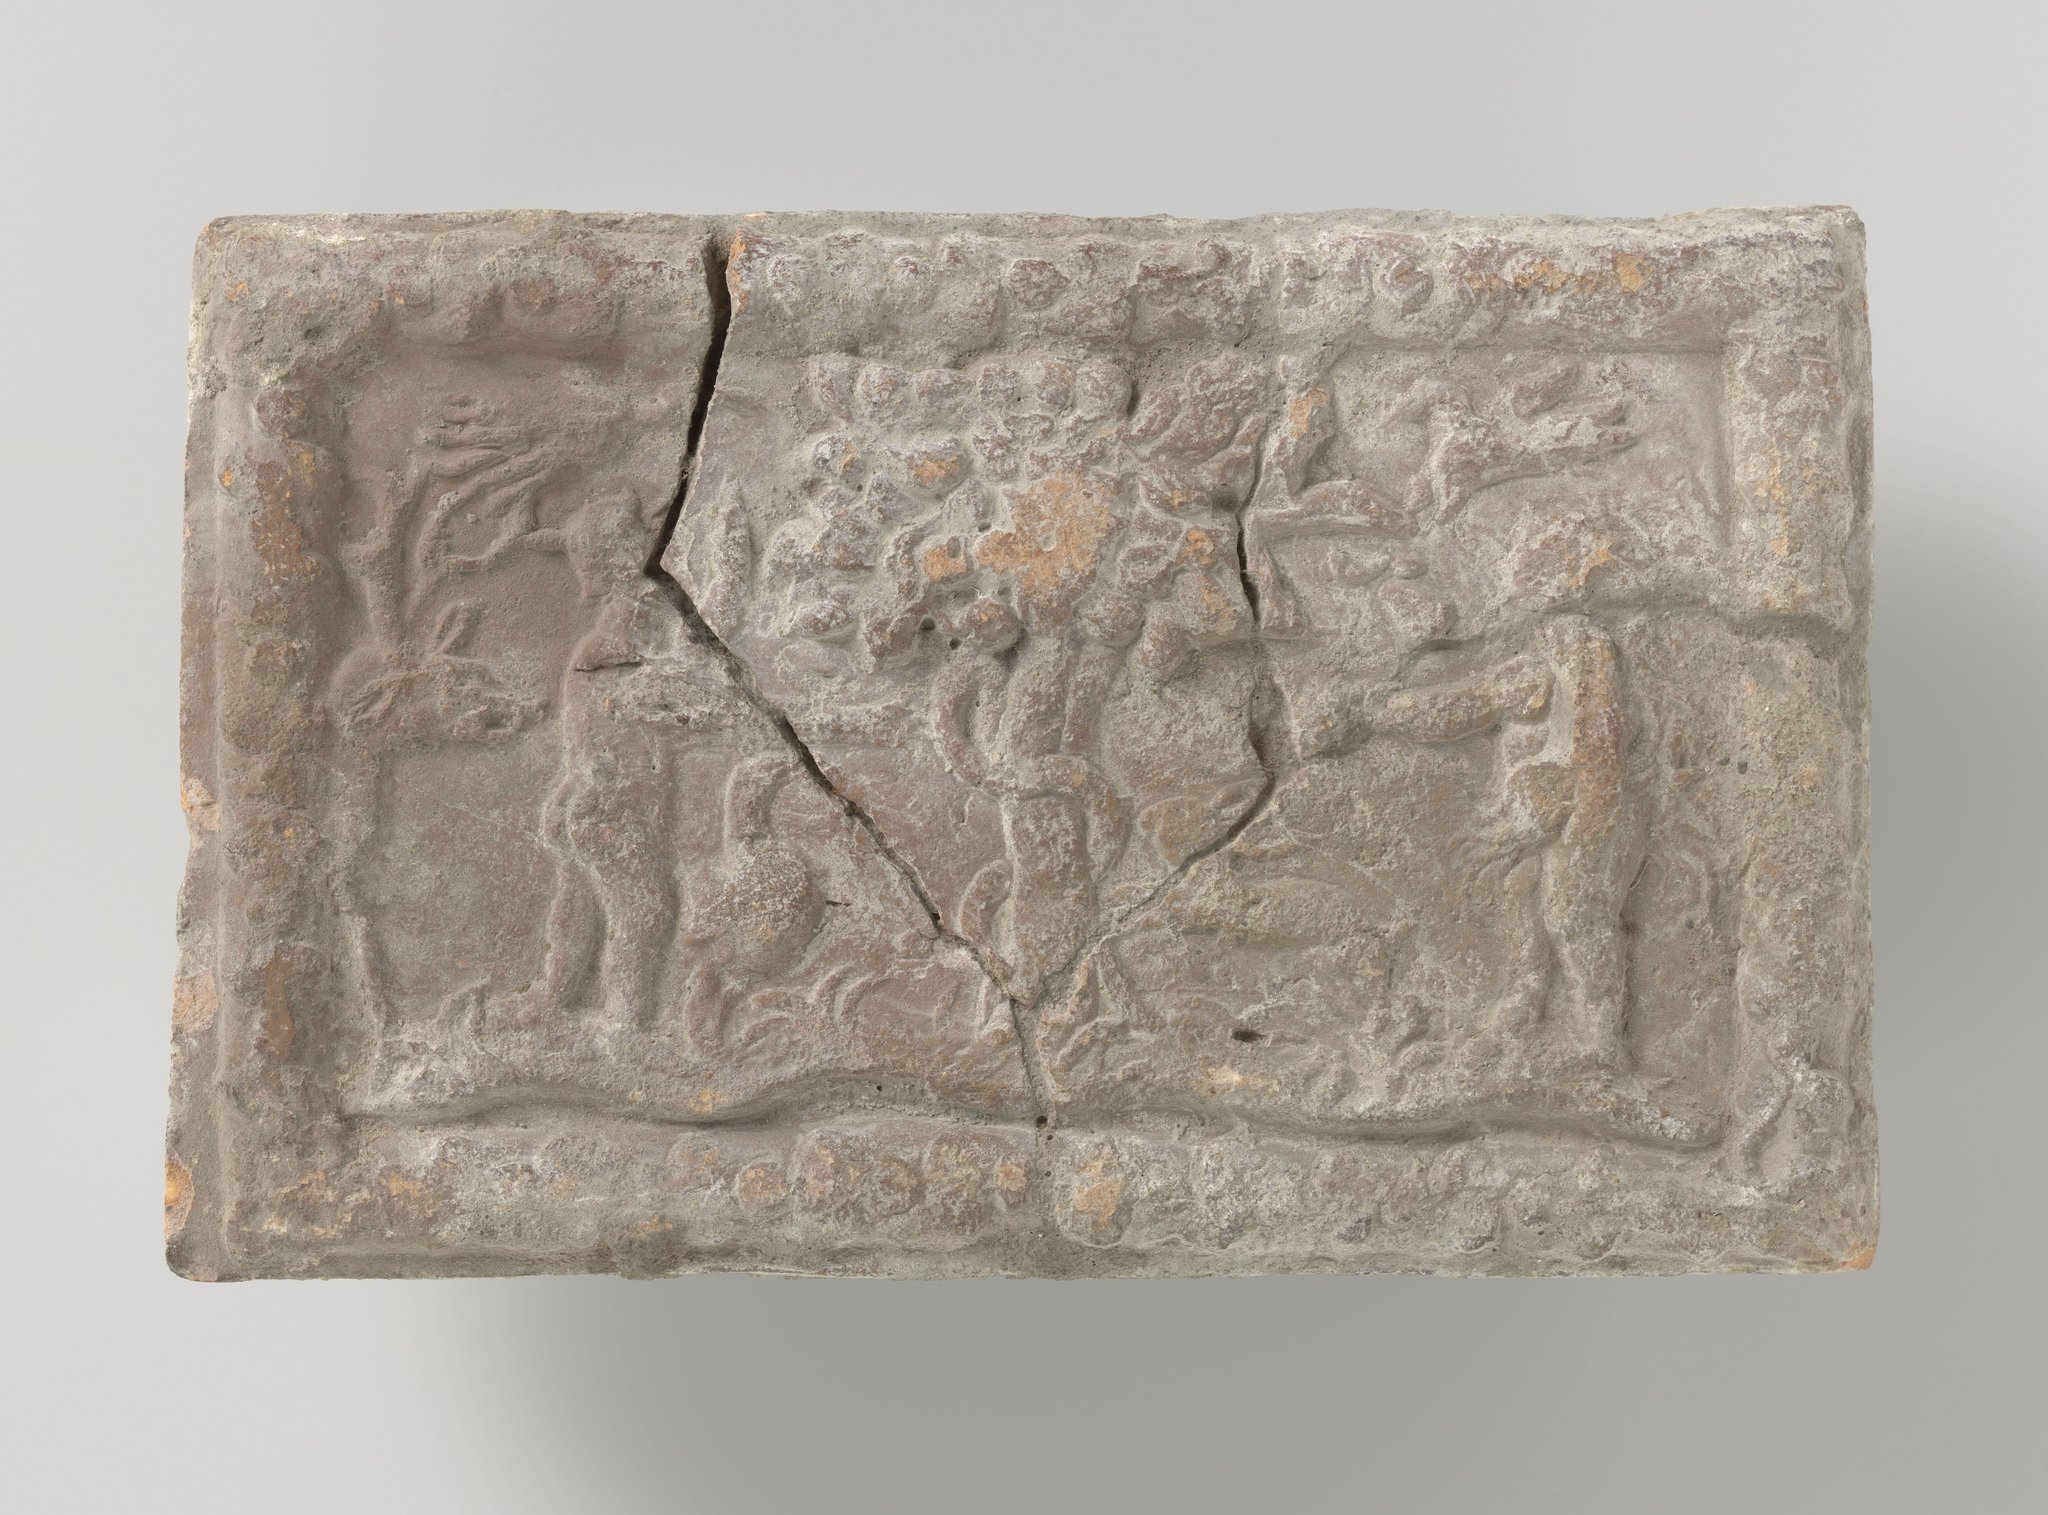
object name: hearthstone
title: Haardsteen met voorstelling van Adam en Eva in het Paradijs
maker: Anonymous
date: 1550-1575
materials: earthenware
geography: southern netherlands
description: Haardsteen met voorstelling van Adam en Eva in het Paradijs.